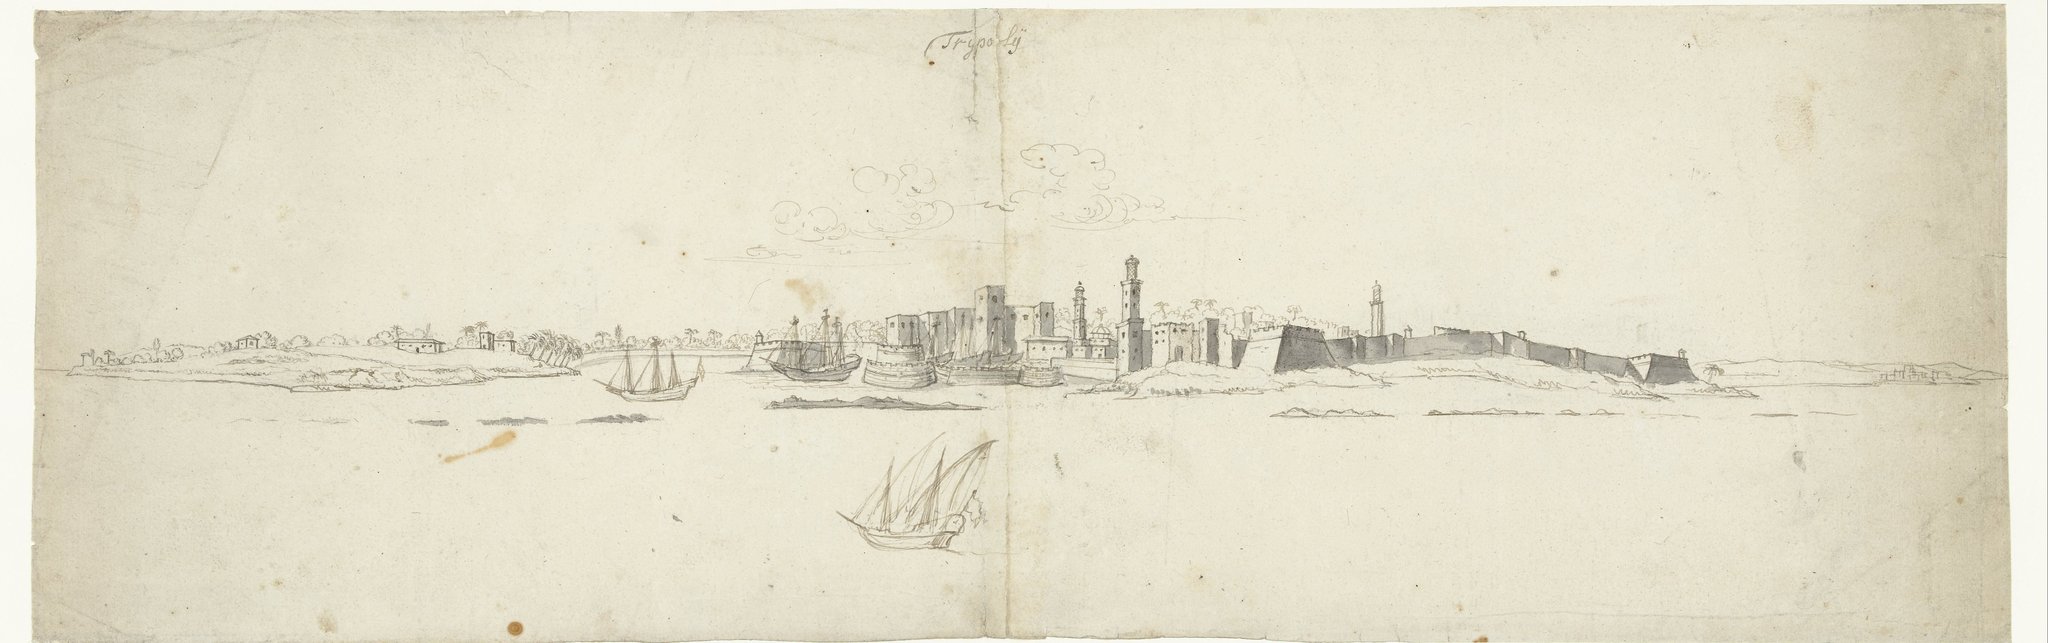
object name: drawing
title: Gezicht op de stad Tripoli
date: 1600-1699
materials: chalk, ink, paper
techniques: brush, pen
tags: harbour, prospect of city, town panorama, silhouette of city